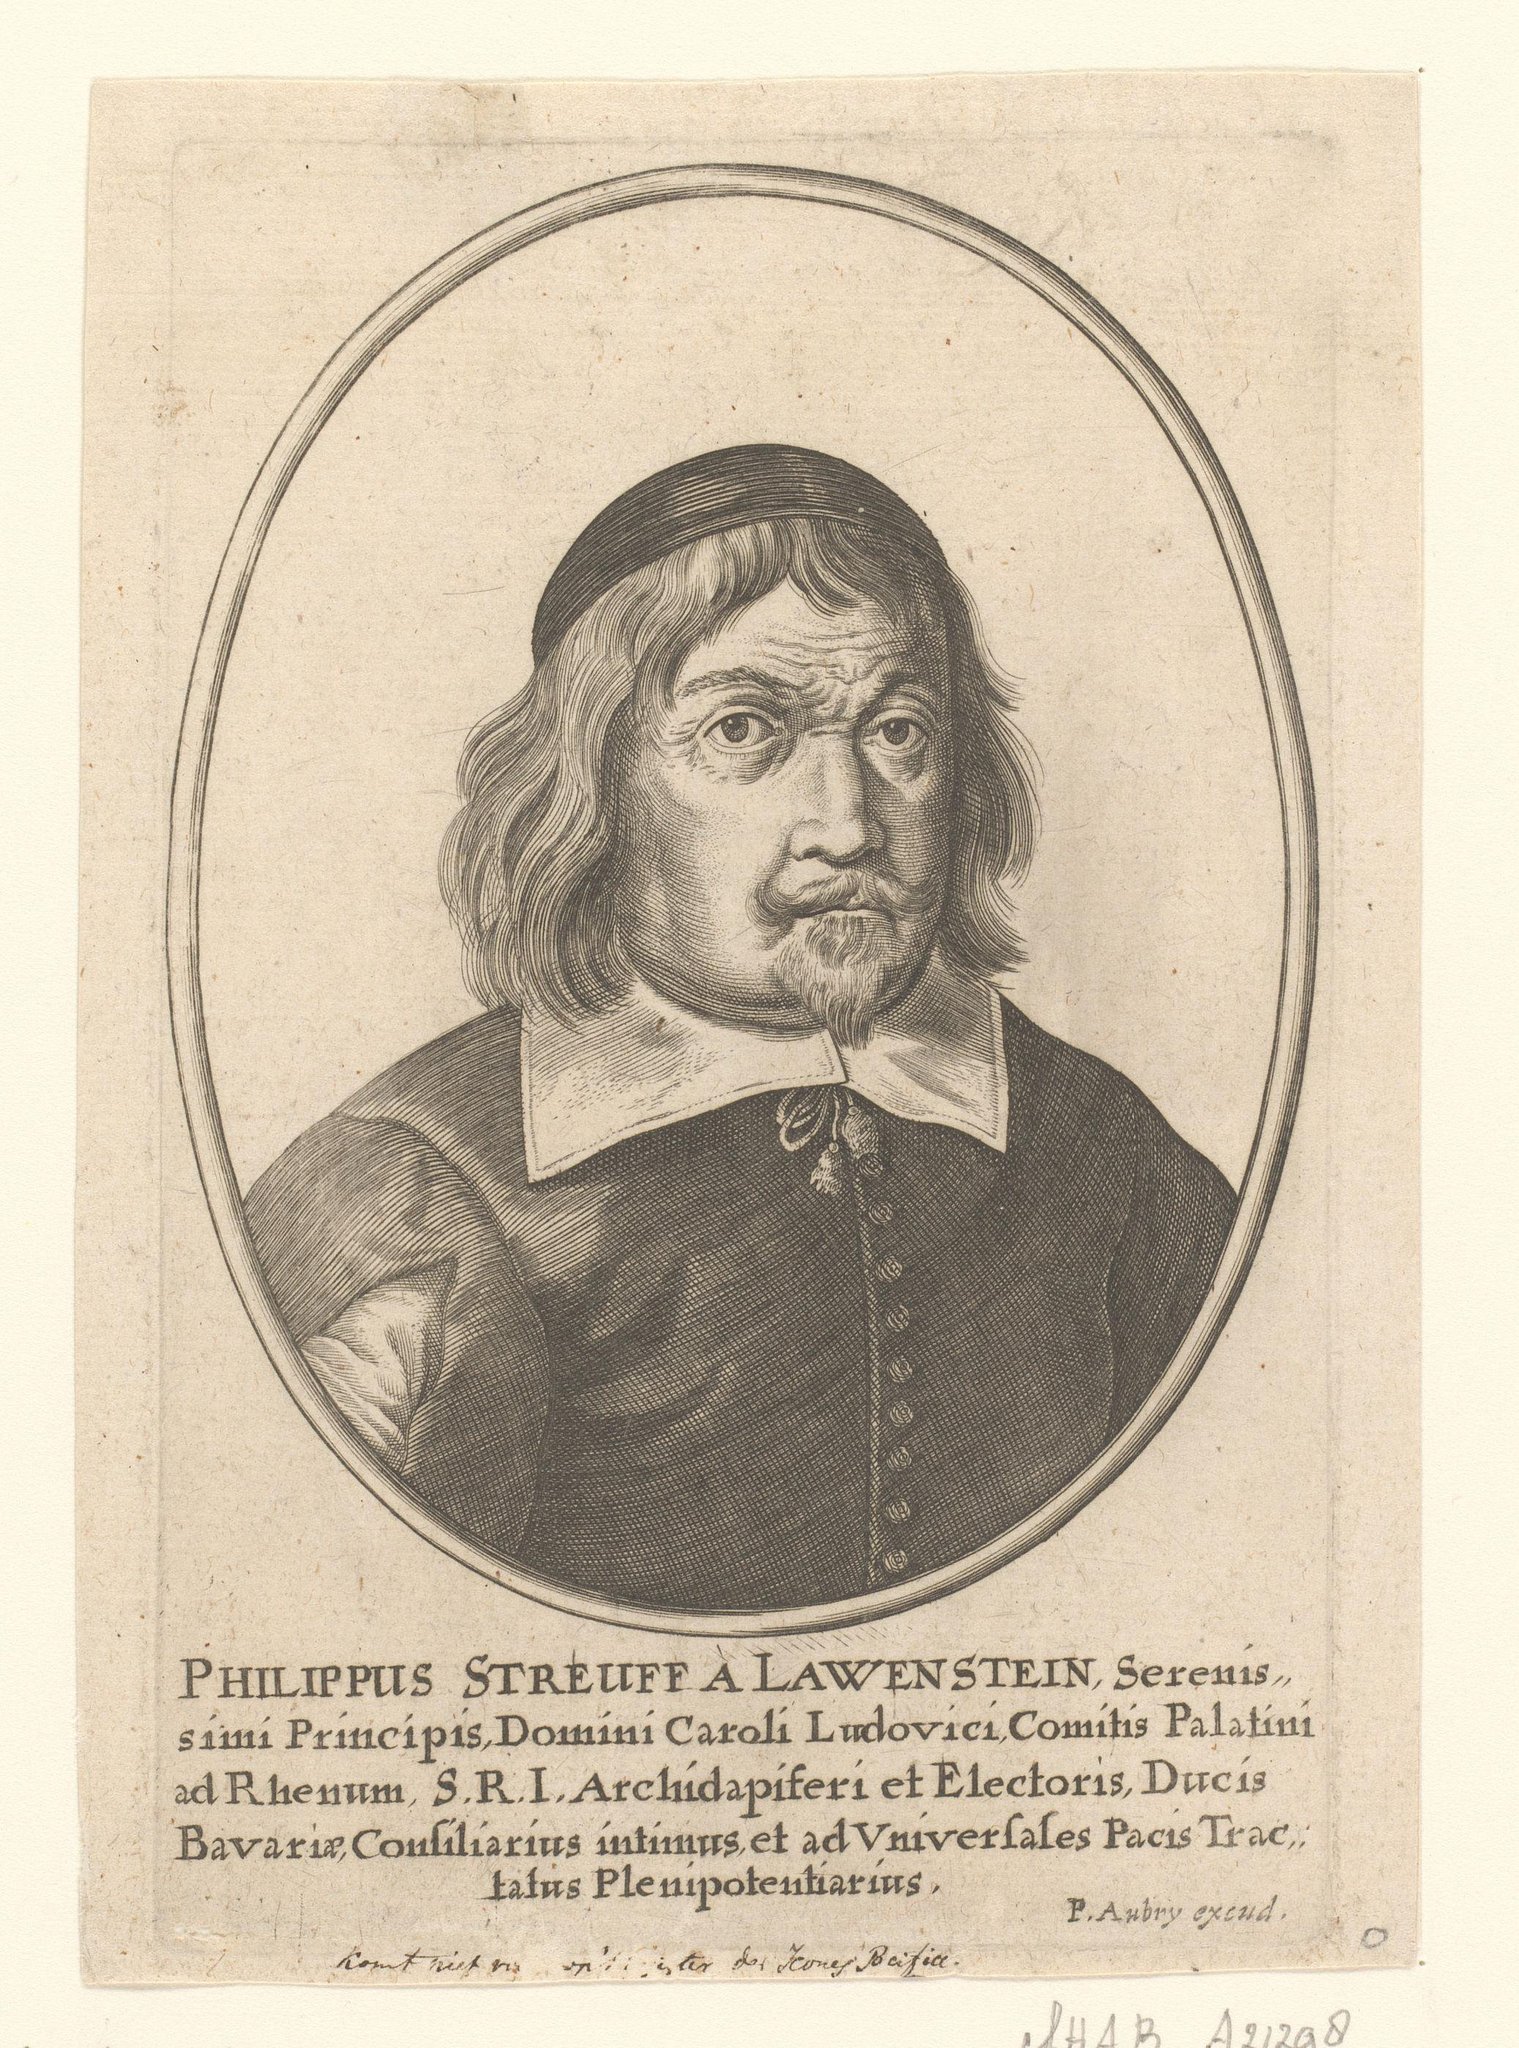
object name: print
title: Portret van Philipp Streuff von Lauenstein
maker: Anonymous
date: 1610-1686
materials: paper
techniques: engraving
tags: alsace, governmental and representative bodies, historical persons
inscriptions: inscription: ‘Komt niet [...] op [...] Bafice.’, collector's mark: Lugt 2228